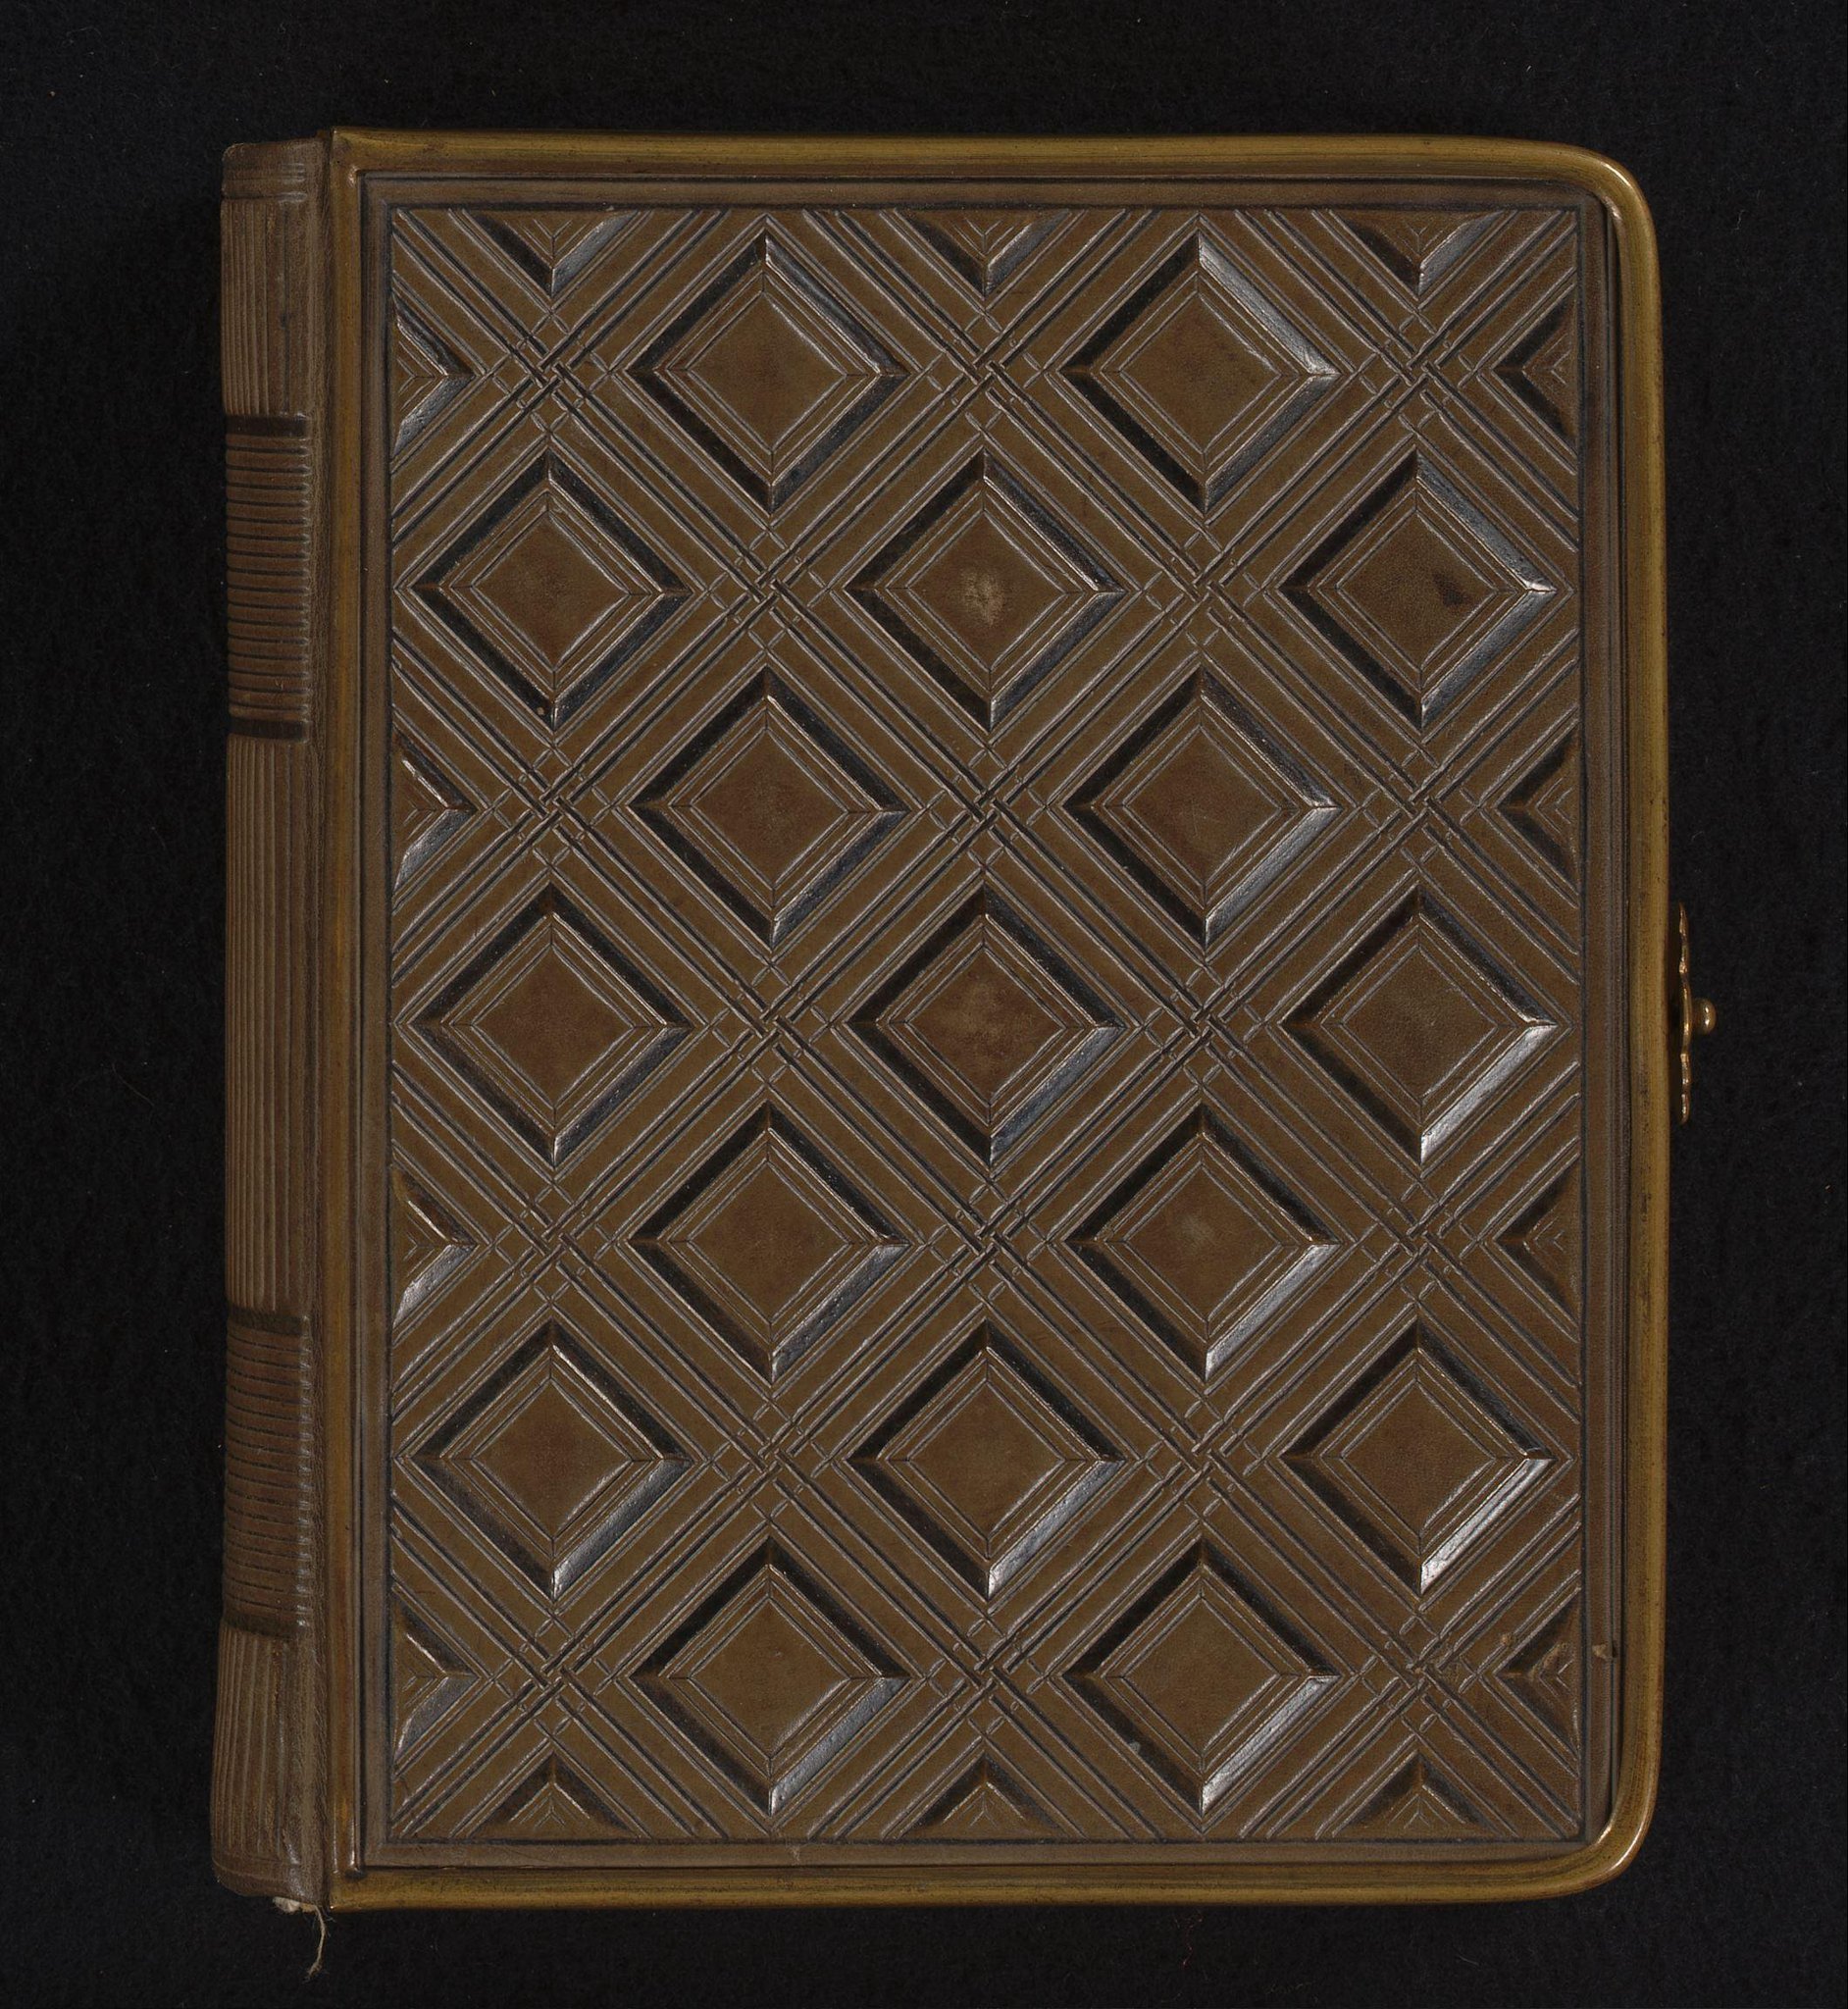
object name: photograph album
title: Fotoalbum (leeg)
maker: Anonymous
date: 1860-1900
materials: cardboard, copper, leather, paper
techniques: color on snow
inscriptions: collector's mark: ‘DIENST/ VERSPREIDE/ RIJKSKOLLEKTIES/ (...) A 783’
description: Fotoalbum met 30 pagina's met ieder een met gouden lijnen omkaderde passe-partout voor een carte-de-visite.